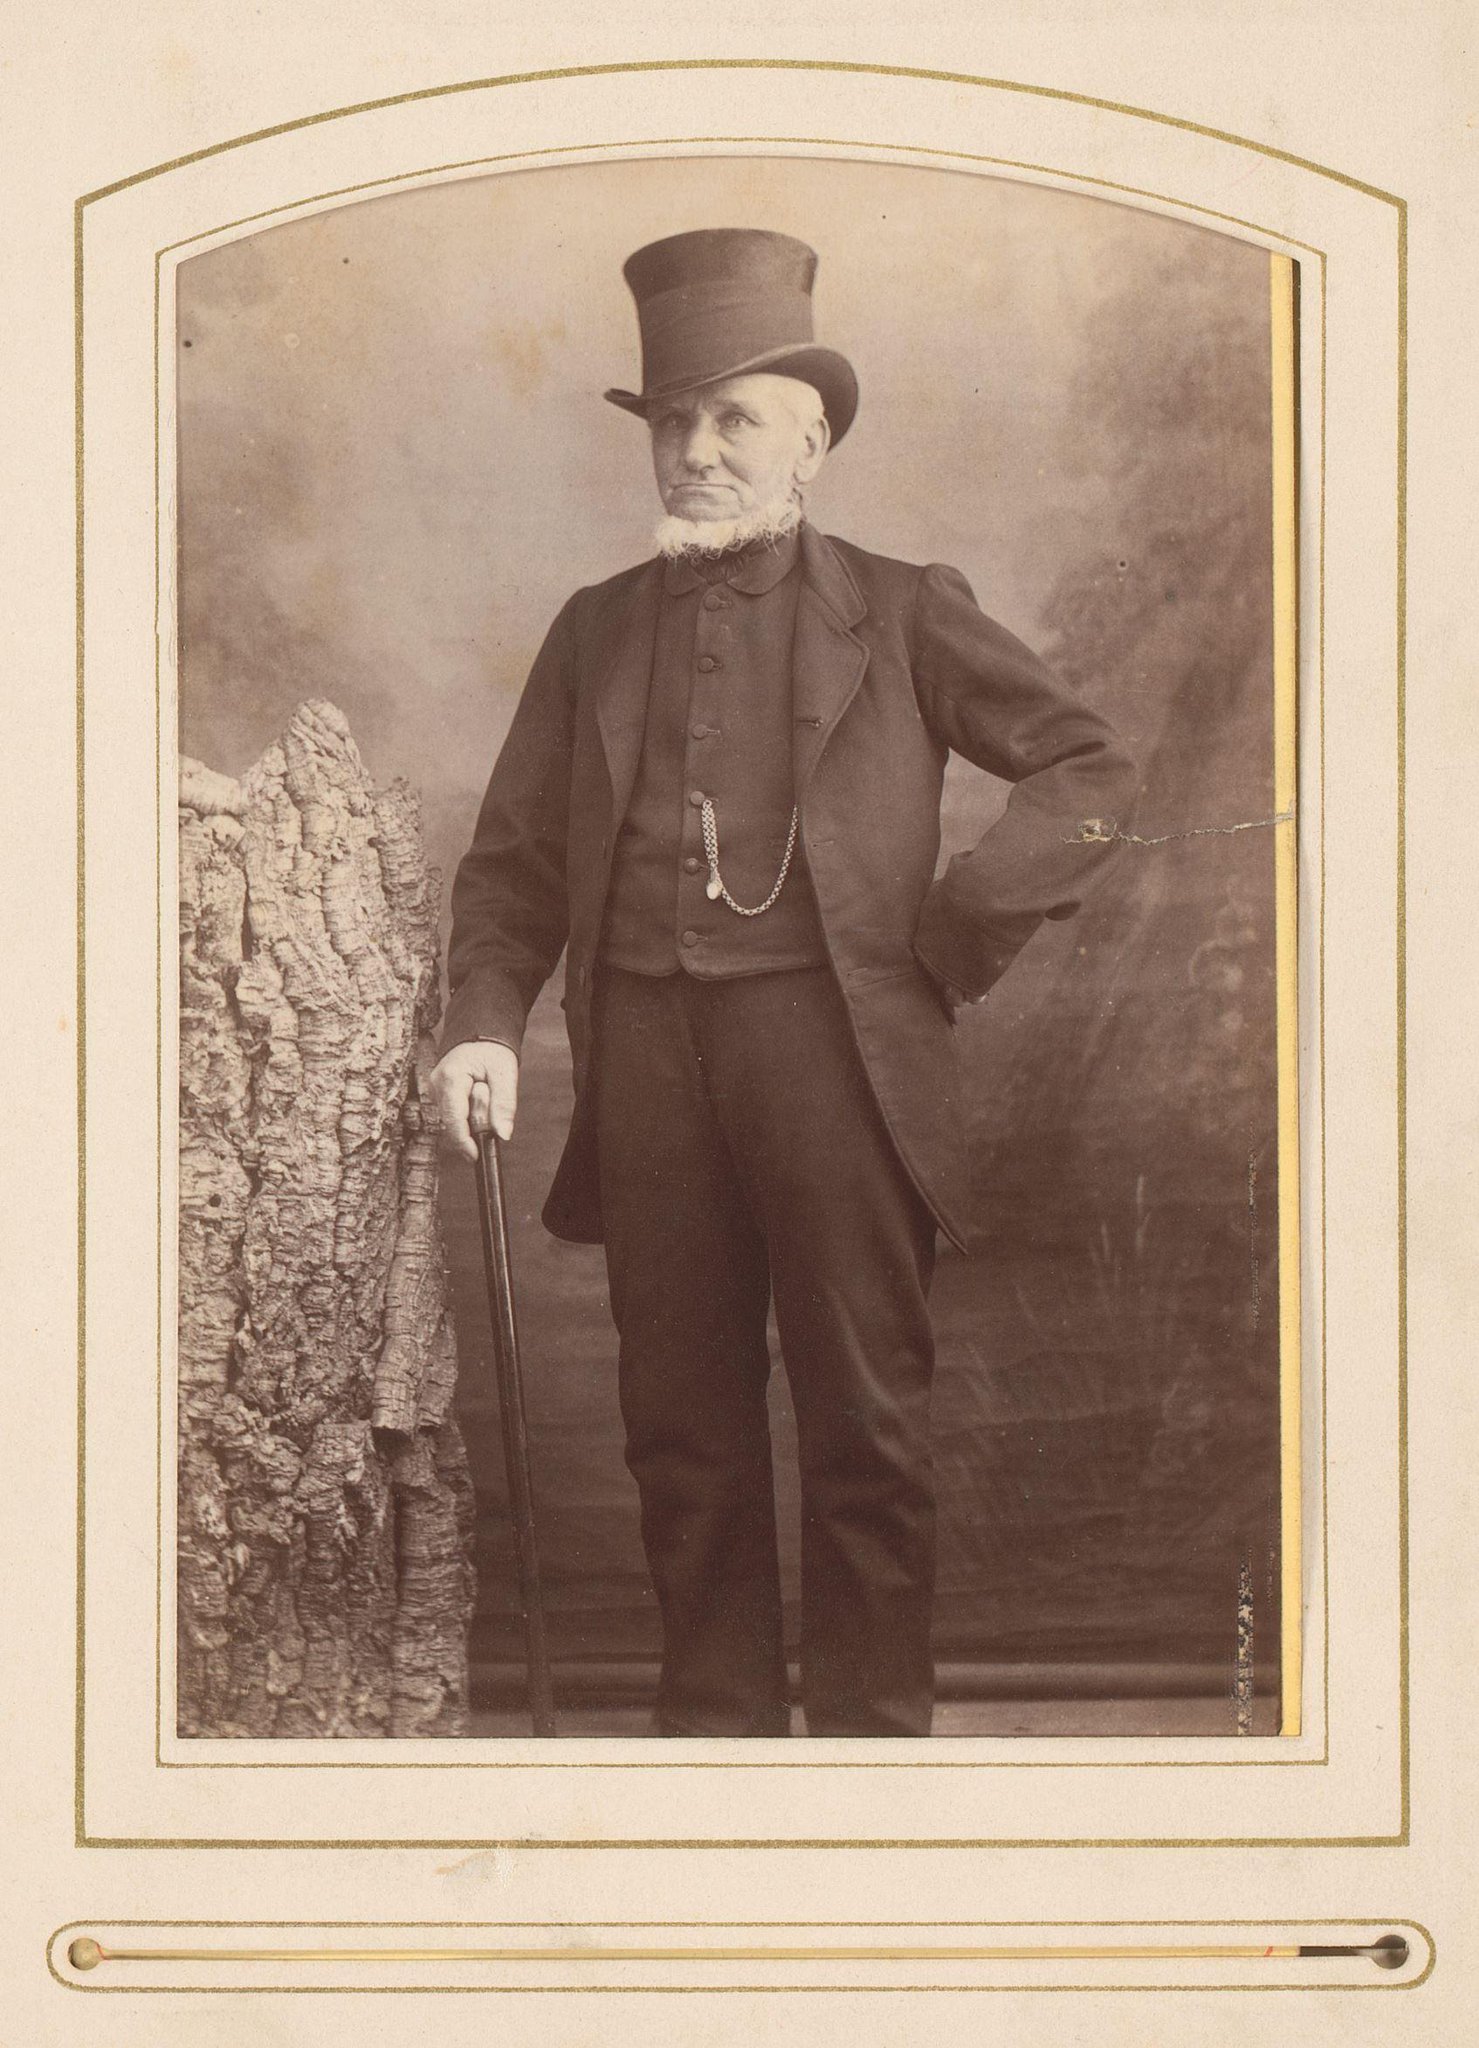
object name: photograph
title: Portret van een man met baard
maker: Anonymous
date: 1860-1900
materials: cardboard, photographic support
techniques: albumen print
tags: adult man, historical persons, beard